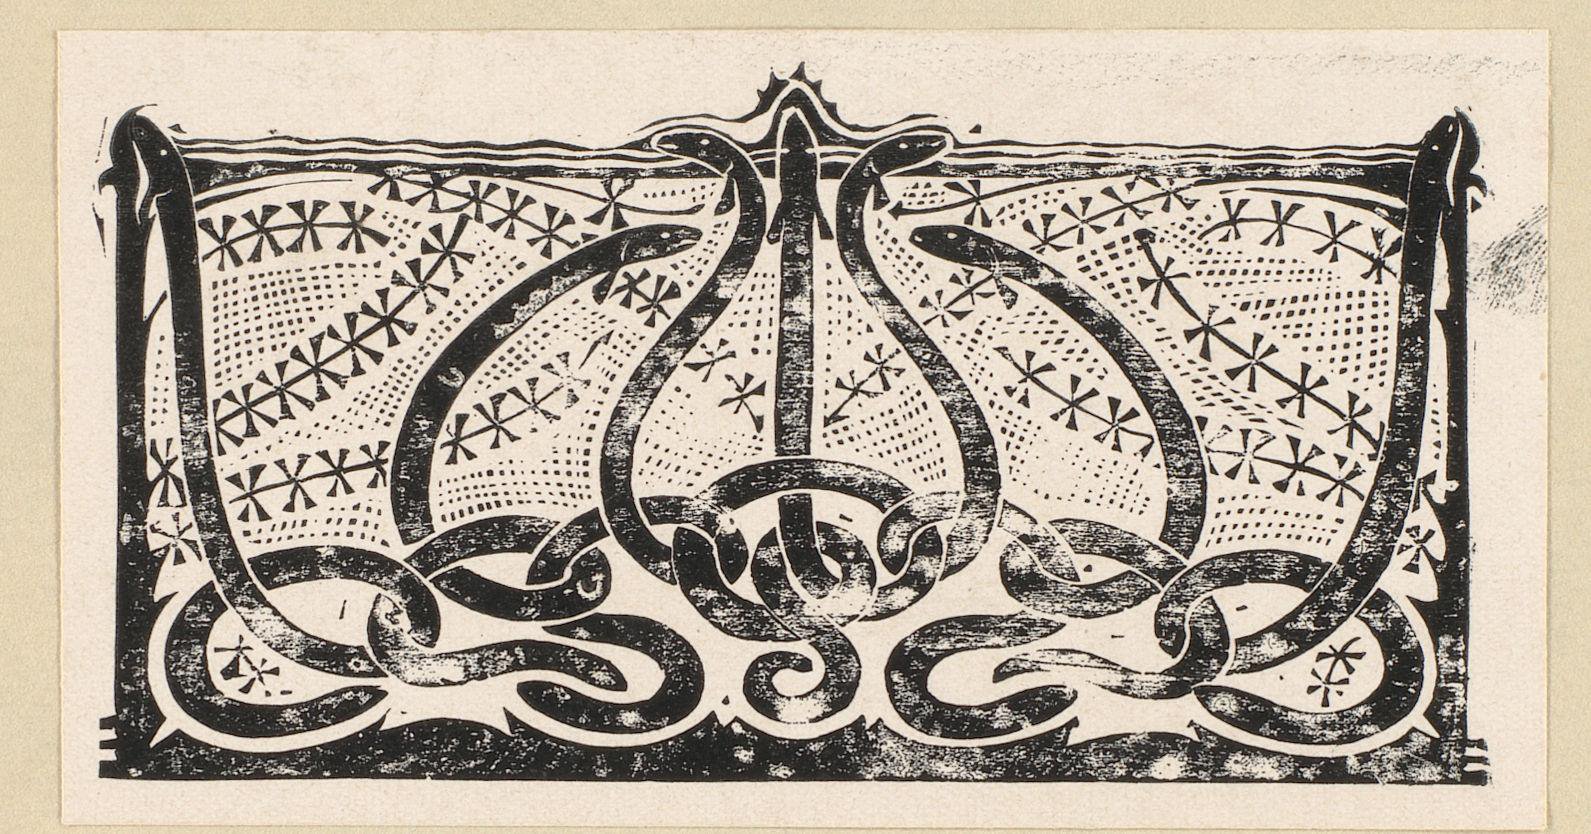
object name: book illustration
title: Titelhoofd met palingen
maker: gerrit willem dijsselhof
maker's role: designer, draughtsman, print maker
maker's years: 1866-1924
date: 1893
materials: paper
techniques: galvanoplasty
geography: amsterdam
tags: other ornament derived from animal forms, eels: eel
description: Titelhoofd uit: Crane, Walter. Kunst en samenleving. [Vertaald uit het Engels door] Jan Veth. Amsterdam: Scheltema & Holkema's Boekhandel, 1894 [1893], p. 131. Later zijn deze afbeeldingen door de uitgever veelvuldig gebruikt voor andere uitgaven. Zie bijvoorbeeld RP-P-1969-415, een catalogus van de in 1894 bij Scheltema & Holkema's Boekhandel verkrijgbare publicaties.